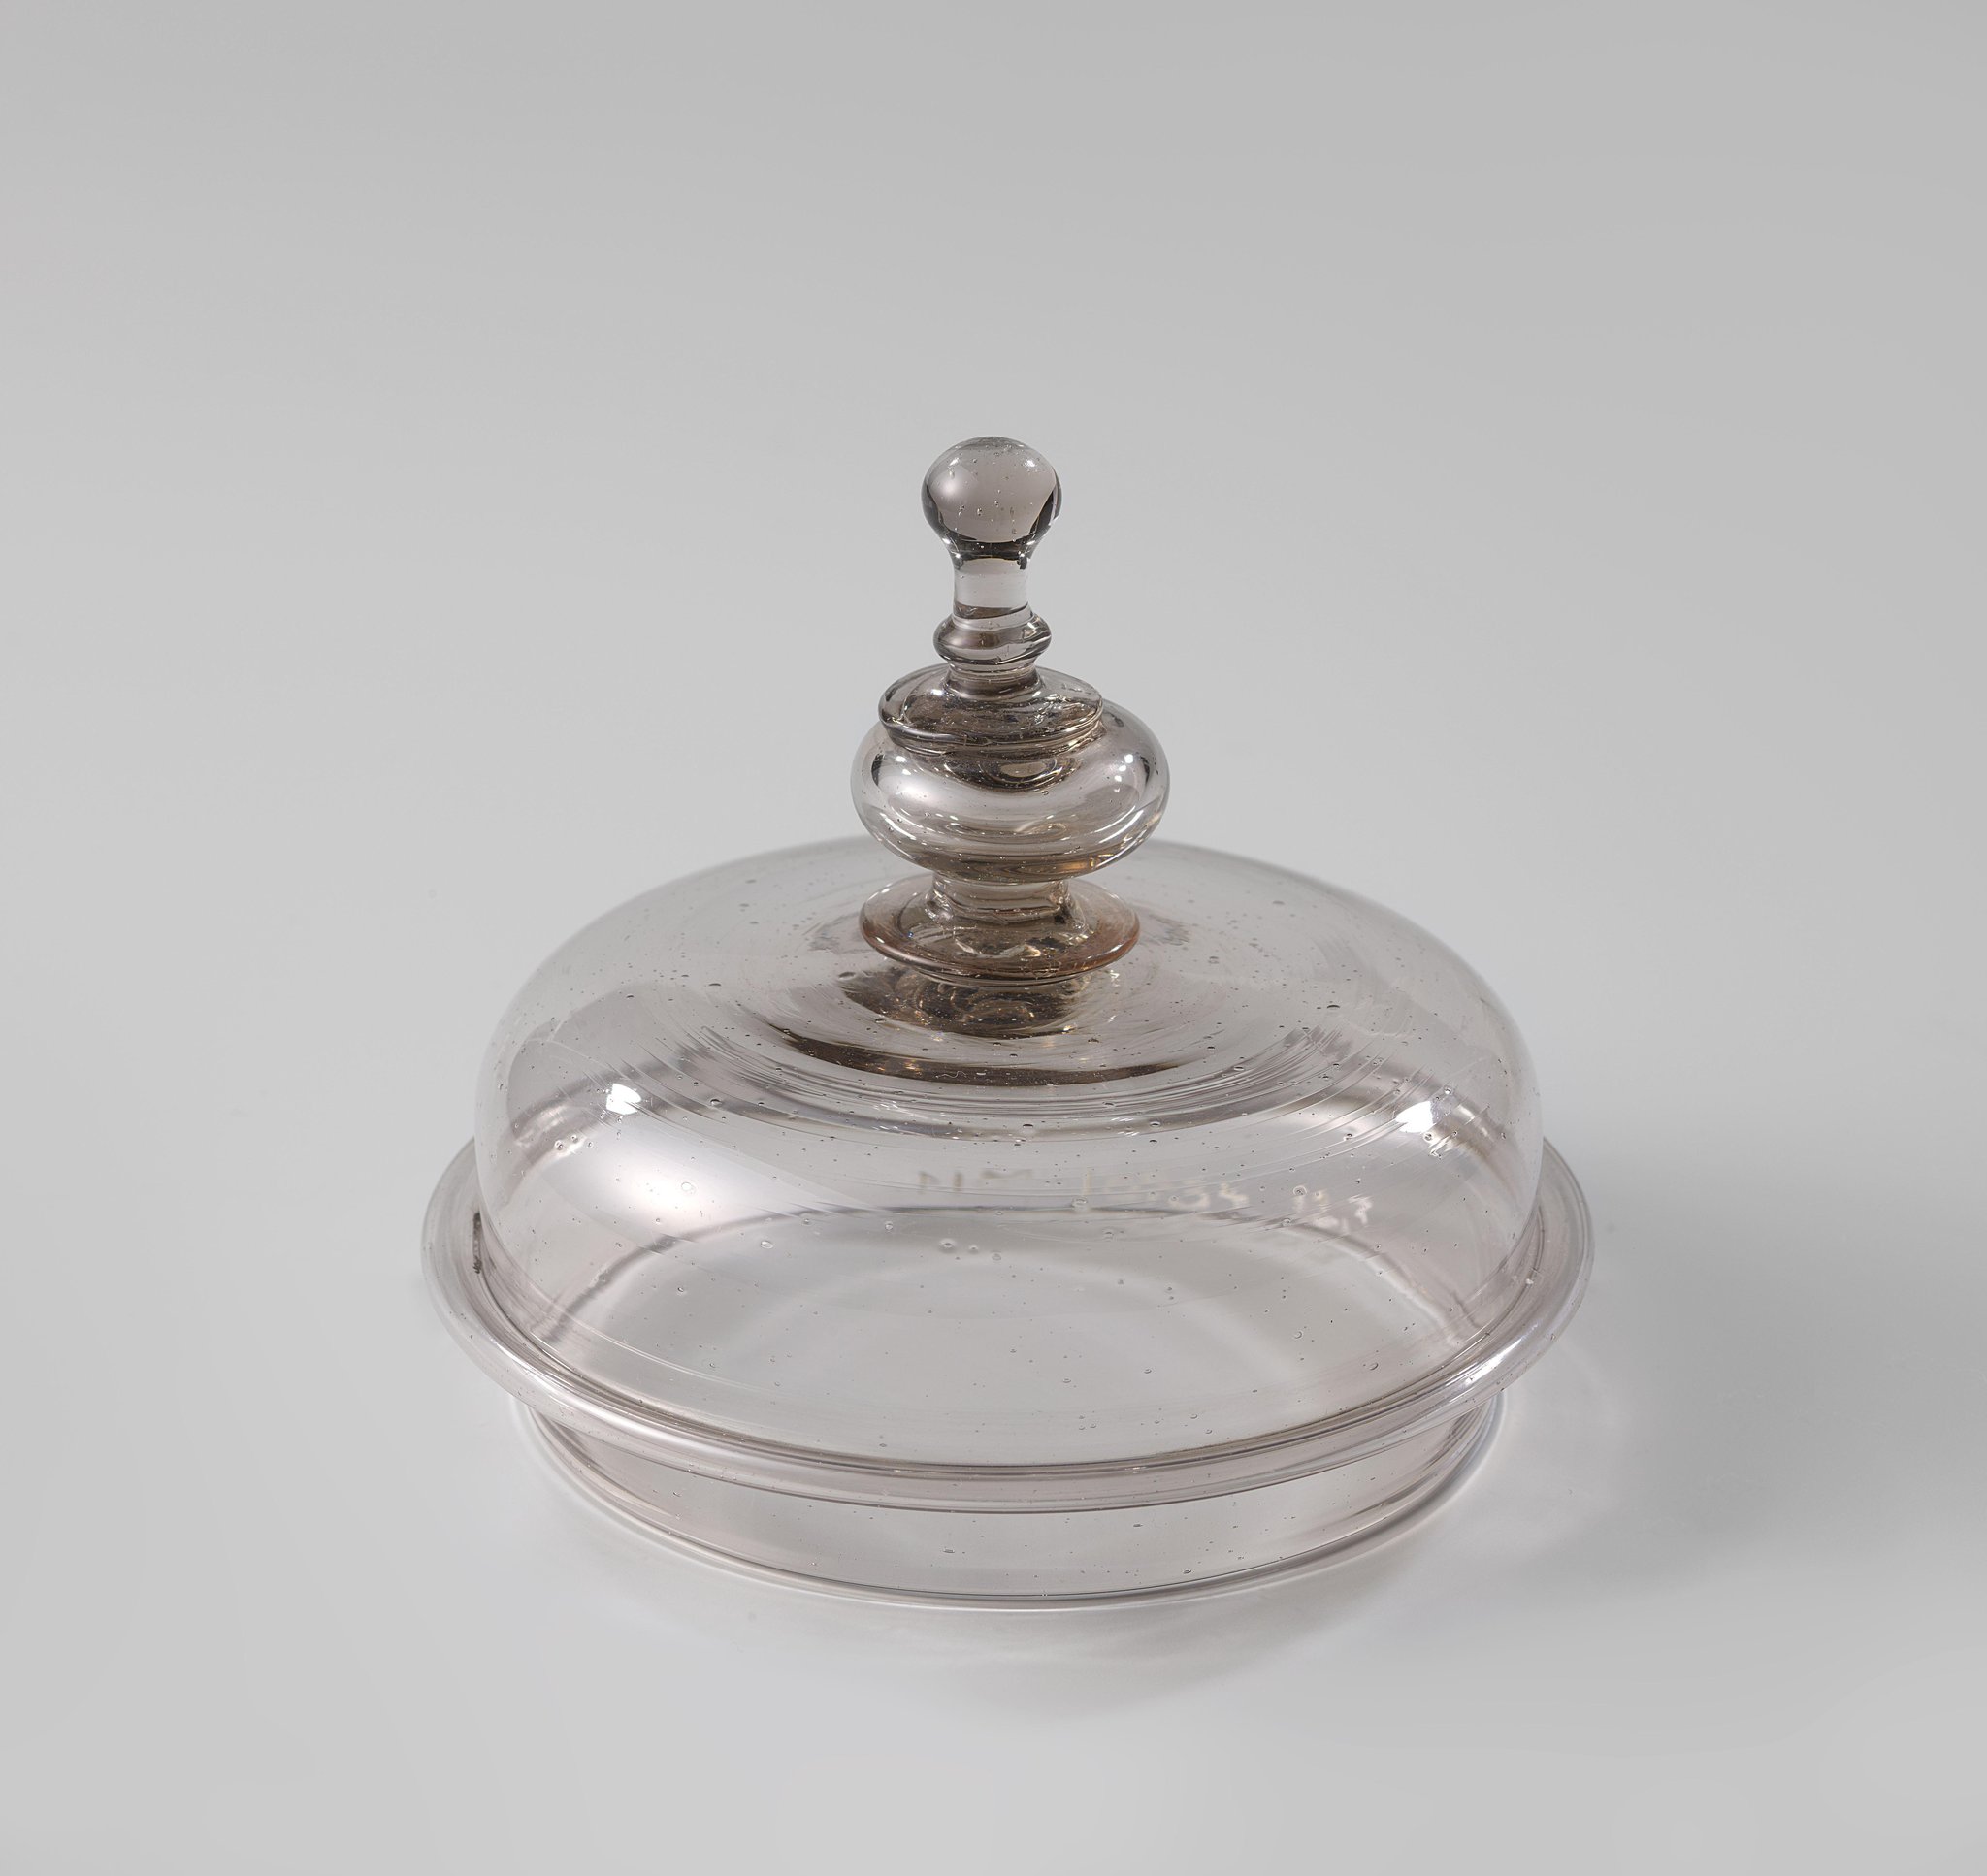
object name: lid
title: Deksel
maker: Anonymous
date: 1700-1799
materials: glass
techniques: glassblowing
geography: netherlands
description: Gewelfde deksel, bekroond met gelede dekselknop, bestaande uit twee knopen, twee schijven en een bolvormige uiteinde.